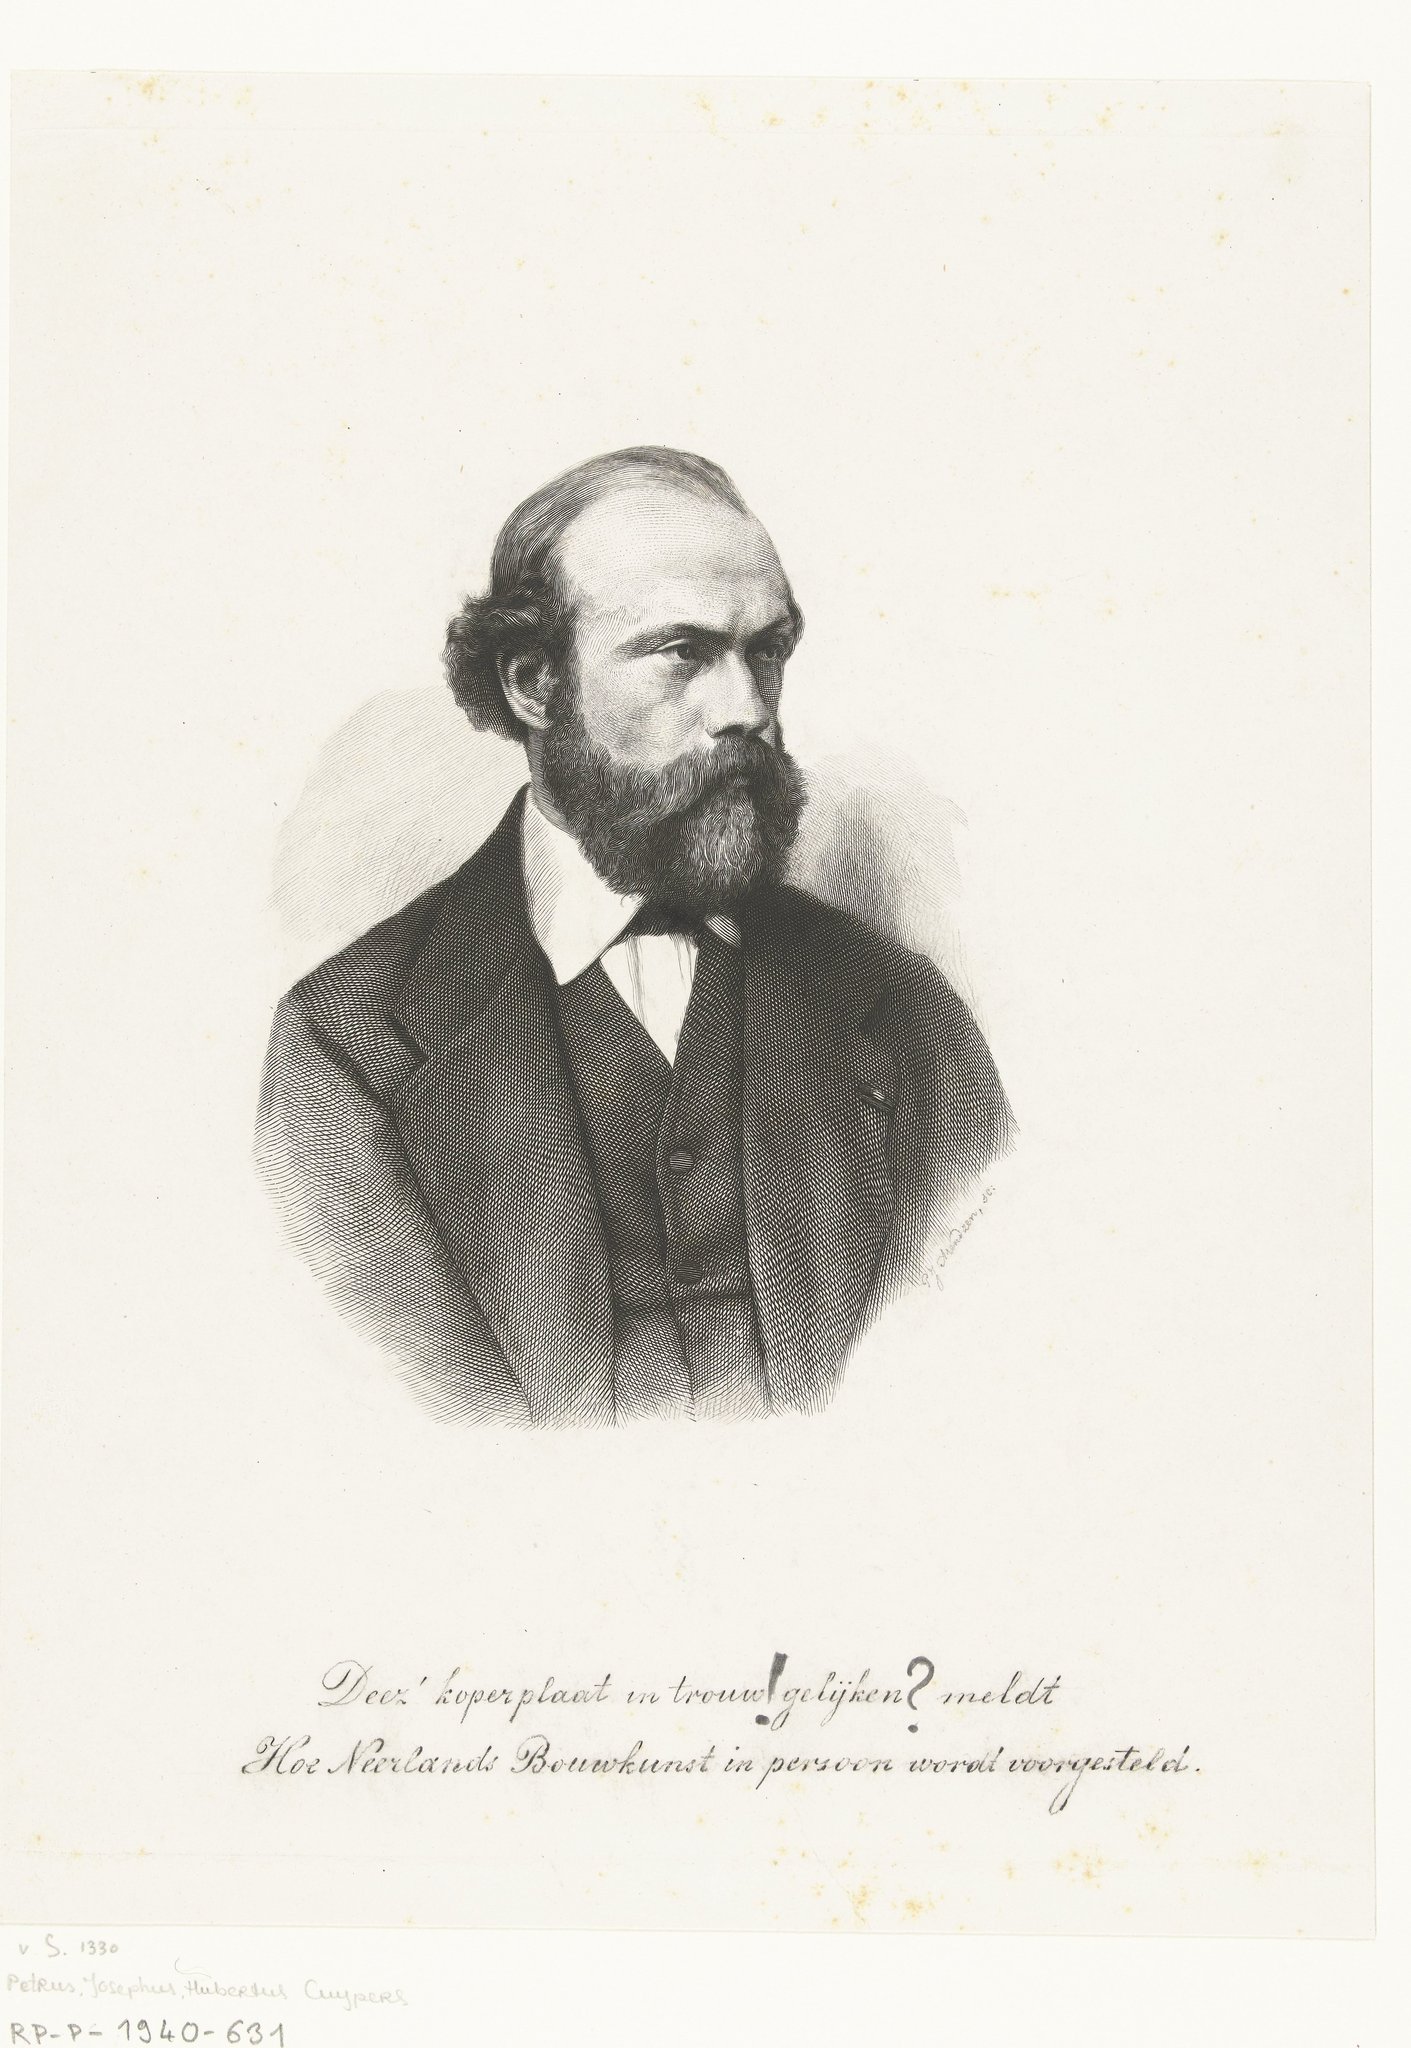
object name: print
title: Portret van P.J.H. Cuypers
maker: petrus johannes arendzen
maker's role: draughtsman, print maker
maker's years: 1846-1932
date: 1856-1880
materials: paper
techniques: engraving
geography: netherlands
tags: draughtsman, pierre joseph hubert cuypers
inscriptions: collector's mark: Lugt 2760, collector's mark: Lugt 2228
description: Borstbeeld van de architect P.J.H. Cuypers op middelbare leeftijd. Onder het portret een vers van twee regels in het Nederlands.